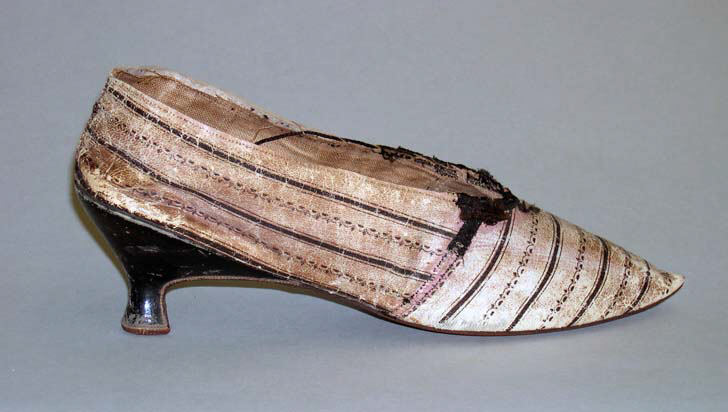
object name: slipper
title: Slippers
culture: french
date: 1785-1790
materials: leather